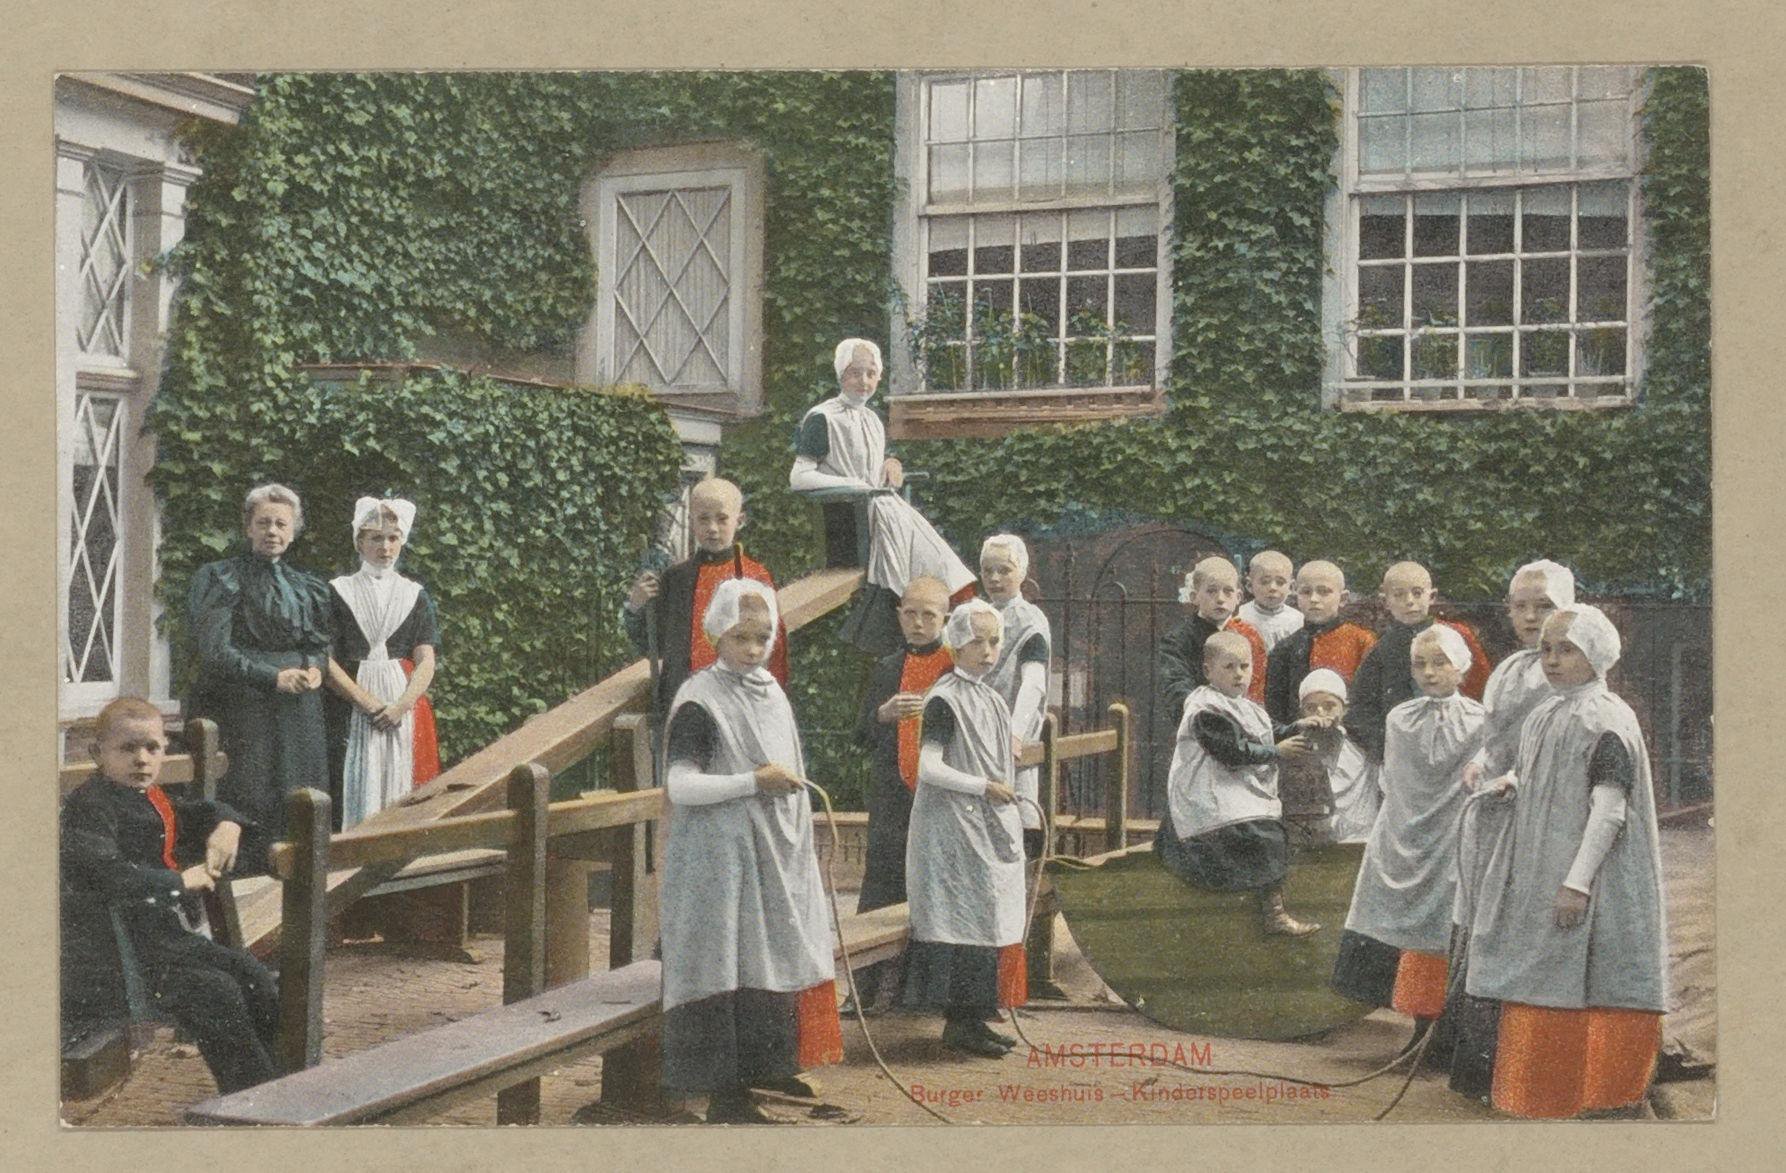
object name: ansichtkaart, prentbriefkaart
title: Speelplaats van het Burgerweeshuis te Amsterdam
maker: Anonymous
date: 1890-1920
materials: cardboard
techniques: four-color autotype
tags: orphanage, orphans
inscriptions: collector's mark: Lugt 1641b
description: Onderwerpsrubriek binnen de Atlas Amsterdam: Armwezen en liefdadige instellingen: I. Stadsinrichtingen: Burgerweeshuis.